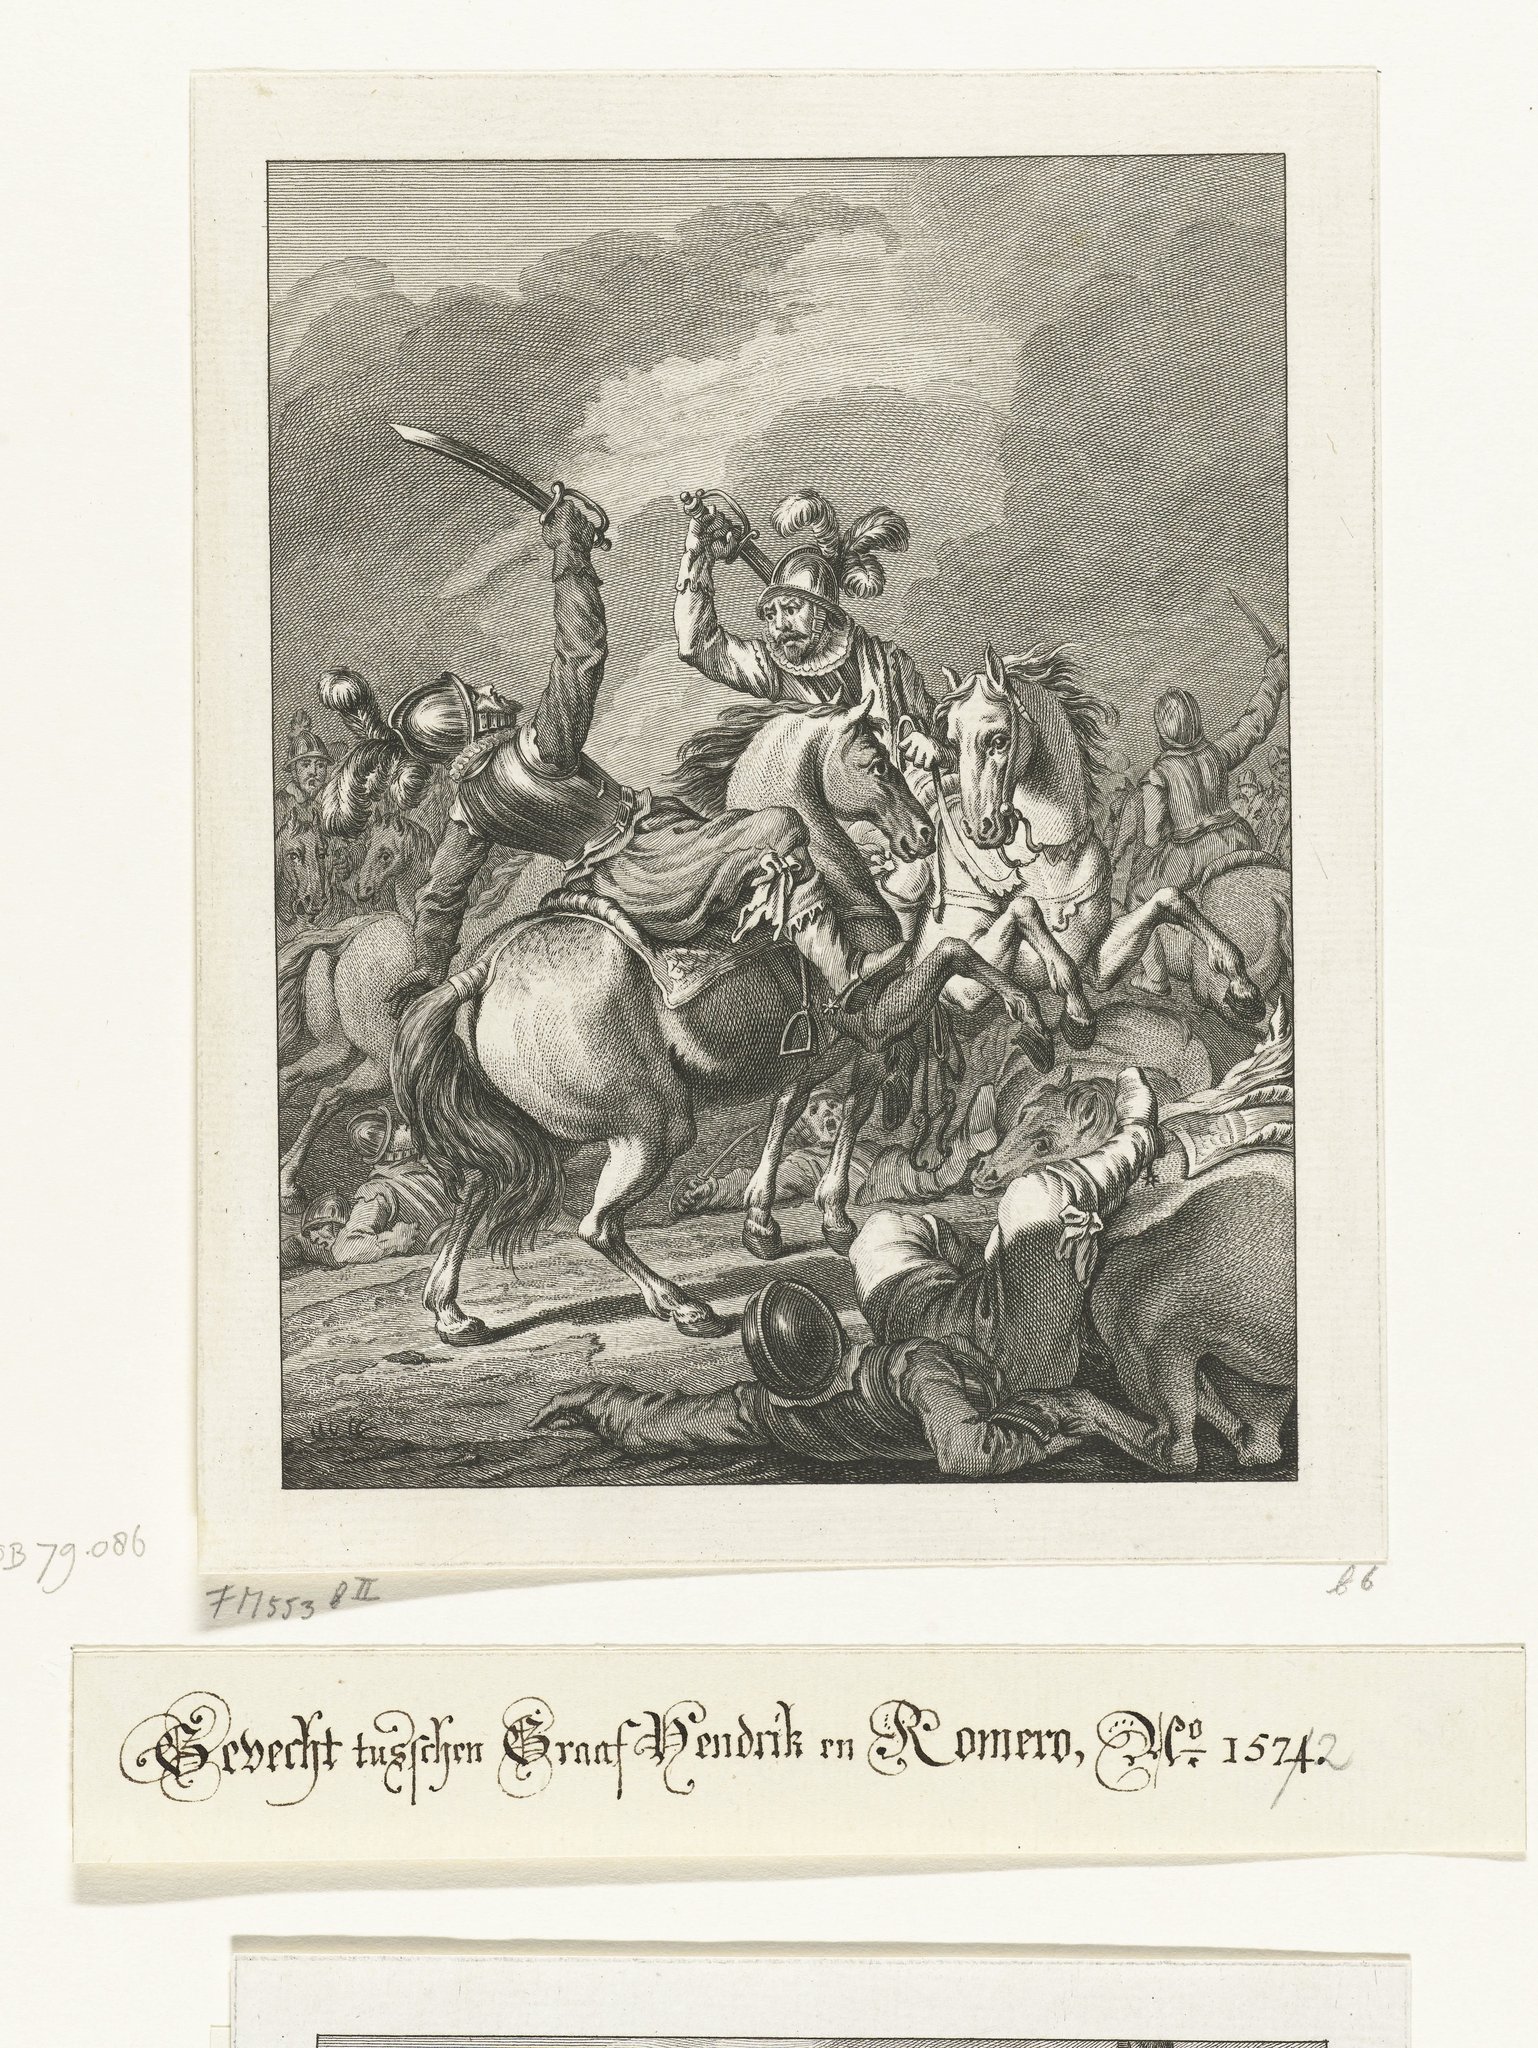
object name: print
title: Gevecht tussen Romero en Hendrik van Nassau bij Mons, 1572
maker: theodoor koning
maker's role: print maker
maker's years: 1748-1829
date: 1780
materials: paper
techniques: etching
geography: northern netherlands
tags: battle, fighting in general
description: Illustratie voor: J. Nomsz, Willem de eerste, of de grondlegging der Nederlandsche vryheid. : In vier en twintig zangen, Erven van David Klippink, Amsterdam 1779. Staat vóór de letter. Met de handgeschreven titel in pen in bruin op een apart papiertje.